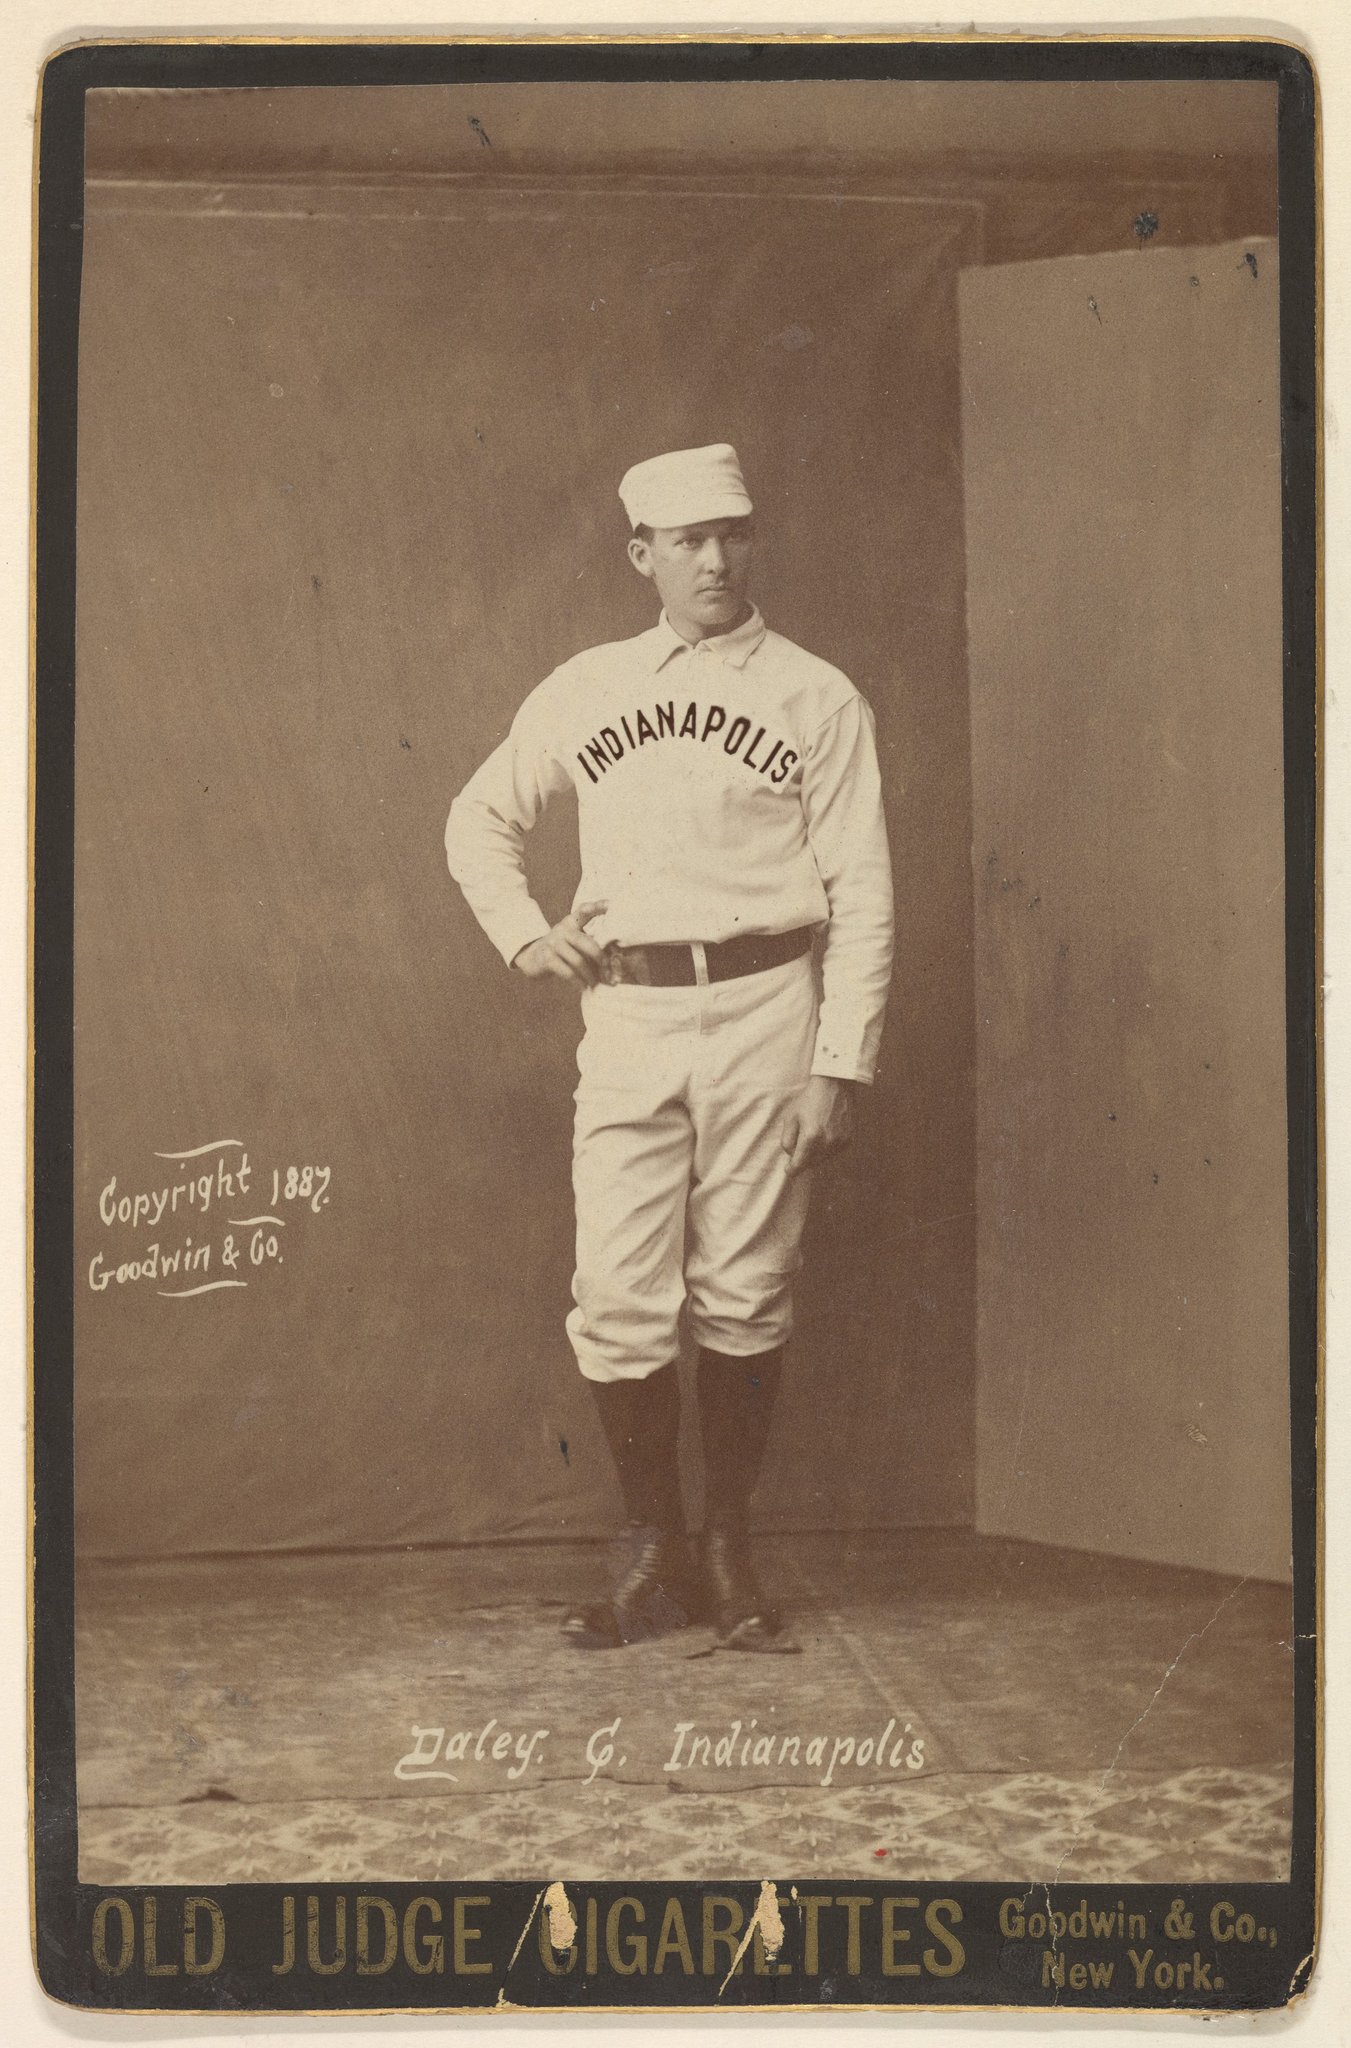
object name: baseball card, photograph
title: Daley, Catcher, Indianapolis, from the series Old Judge Cigarettes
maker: goodwin & company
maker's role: publisher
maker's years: 1850-1950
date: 1887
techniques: albumen silver print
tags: men,portraits,baseball,athletes